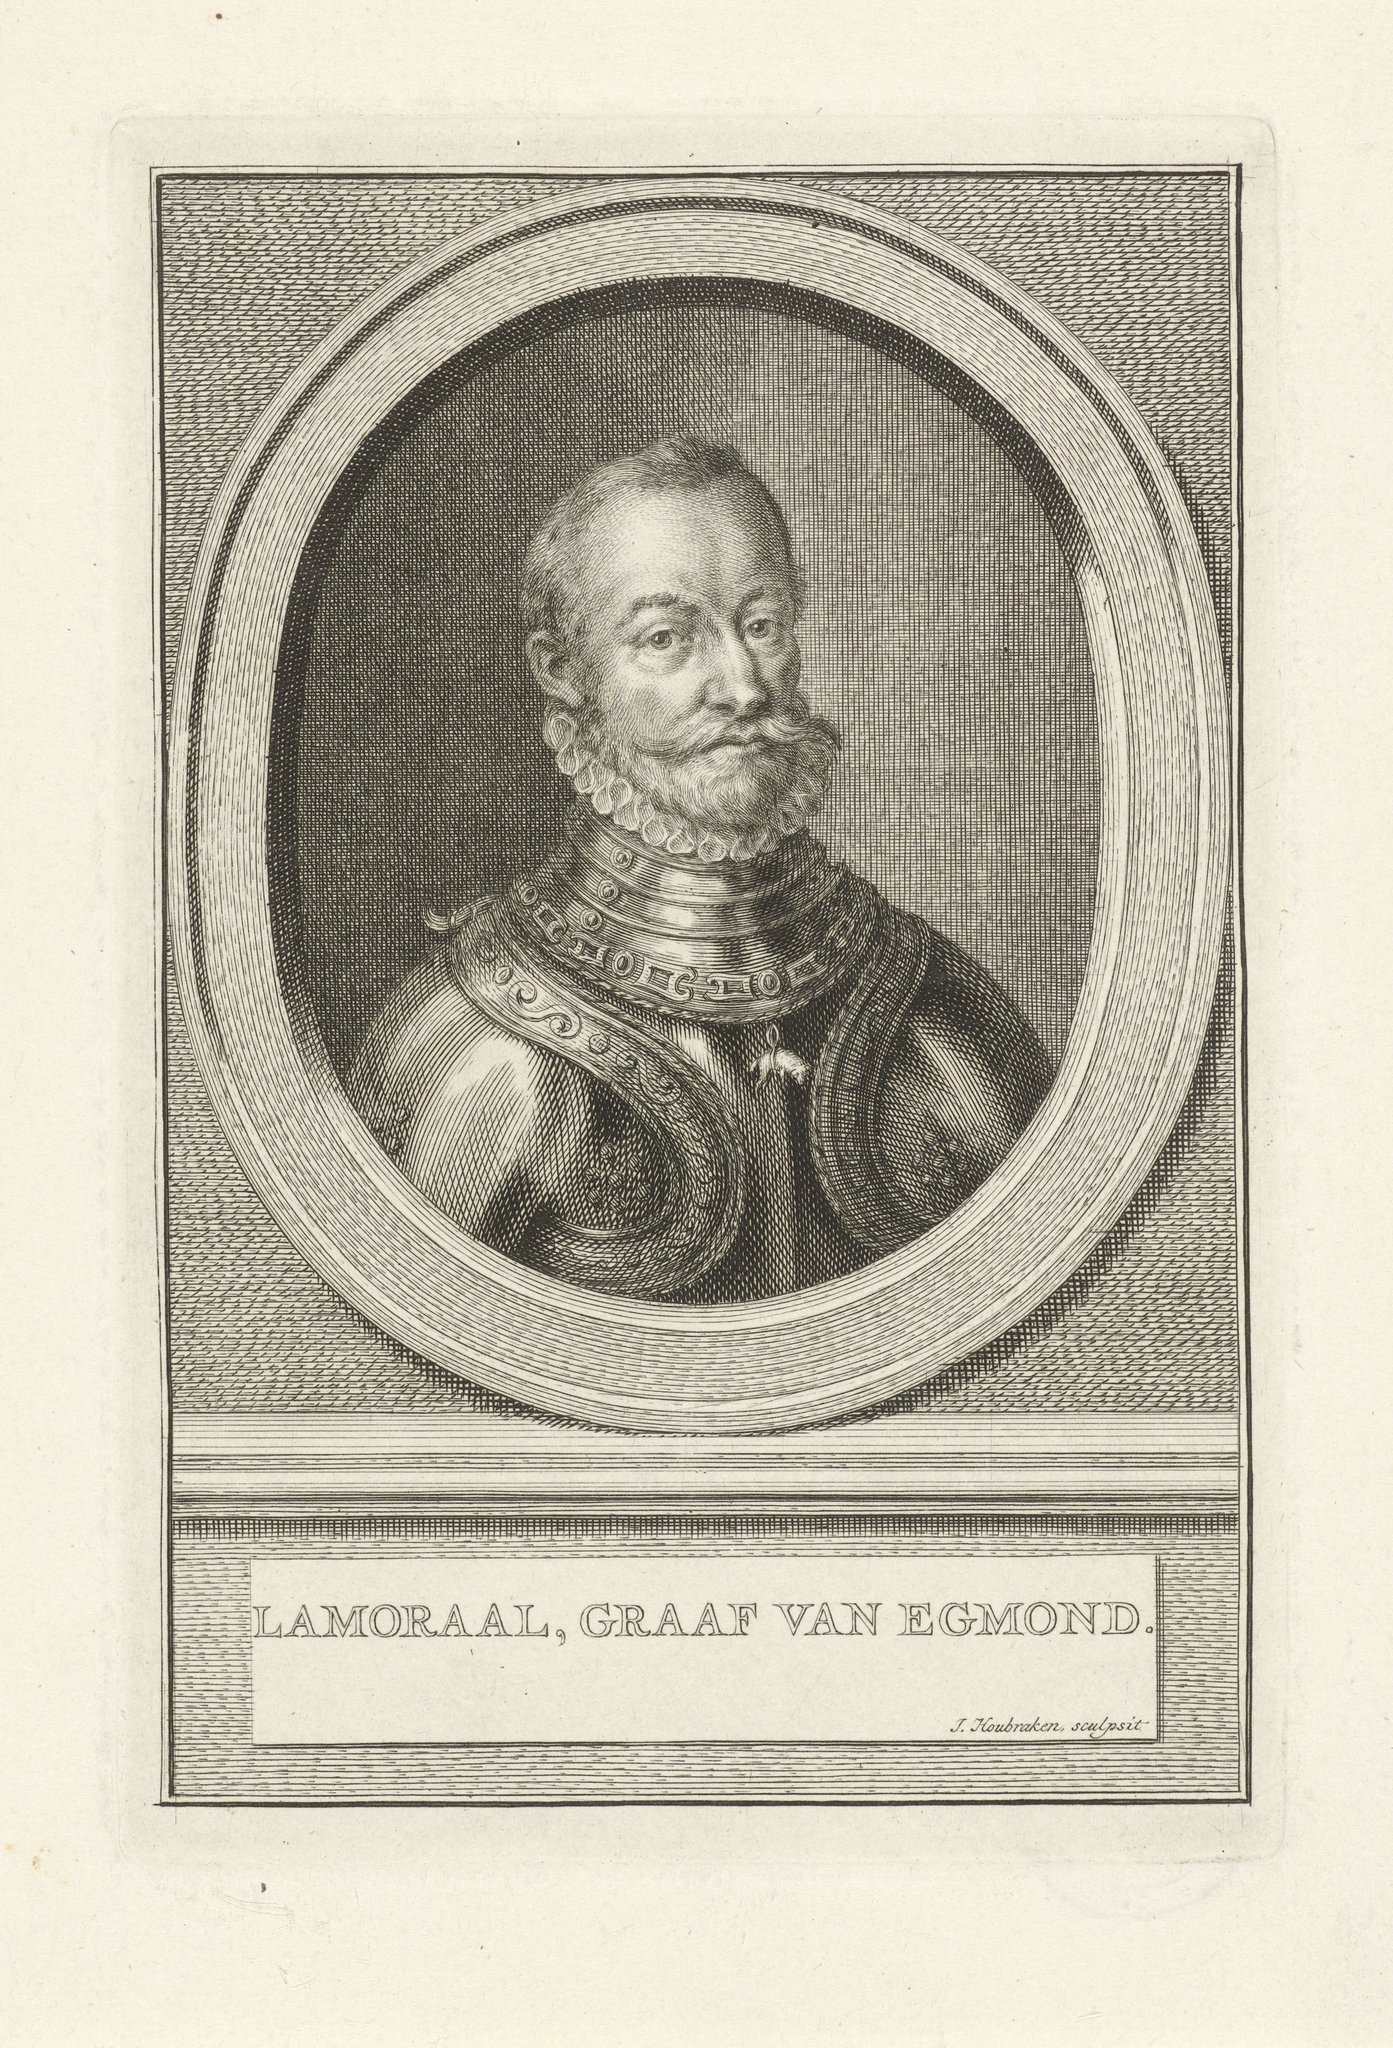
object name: print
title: Portret van Lamoraal, graaf van Egmond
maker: jacob houbraken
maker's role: draughtsman, print maker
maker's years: 1698-1780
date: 1749-1759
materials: paper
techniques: engraving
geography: amsterdam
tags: earl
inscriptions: collector's mark: Lugt 240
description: Prent oorspronkelijk bedoeld voor: Jan Wagenaar, Vaderlandsche historie, vervattende de geschiedenissen der nu Vereenigde Nederlanden, inzonderheid die van Holland (...), 21 delen. Amsterdam, Isaak Tirion, 1749-59.